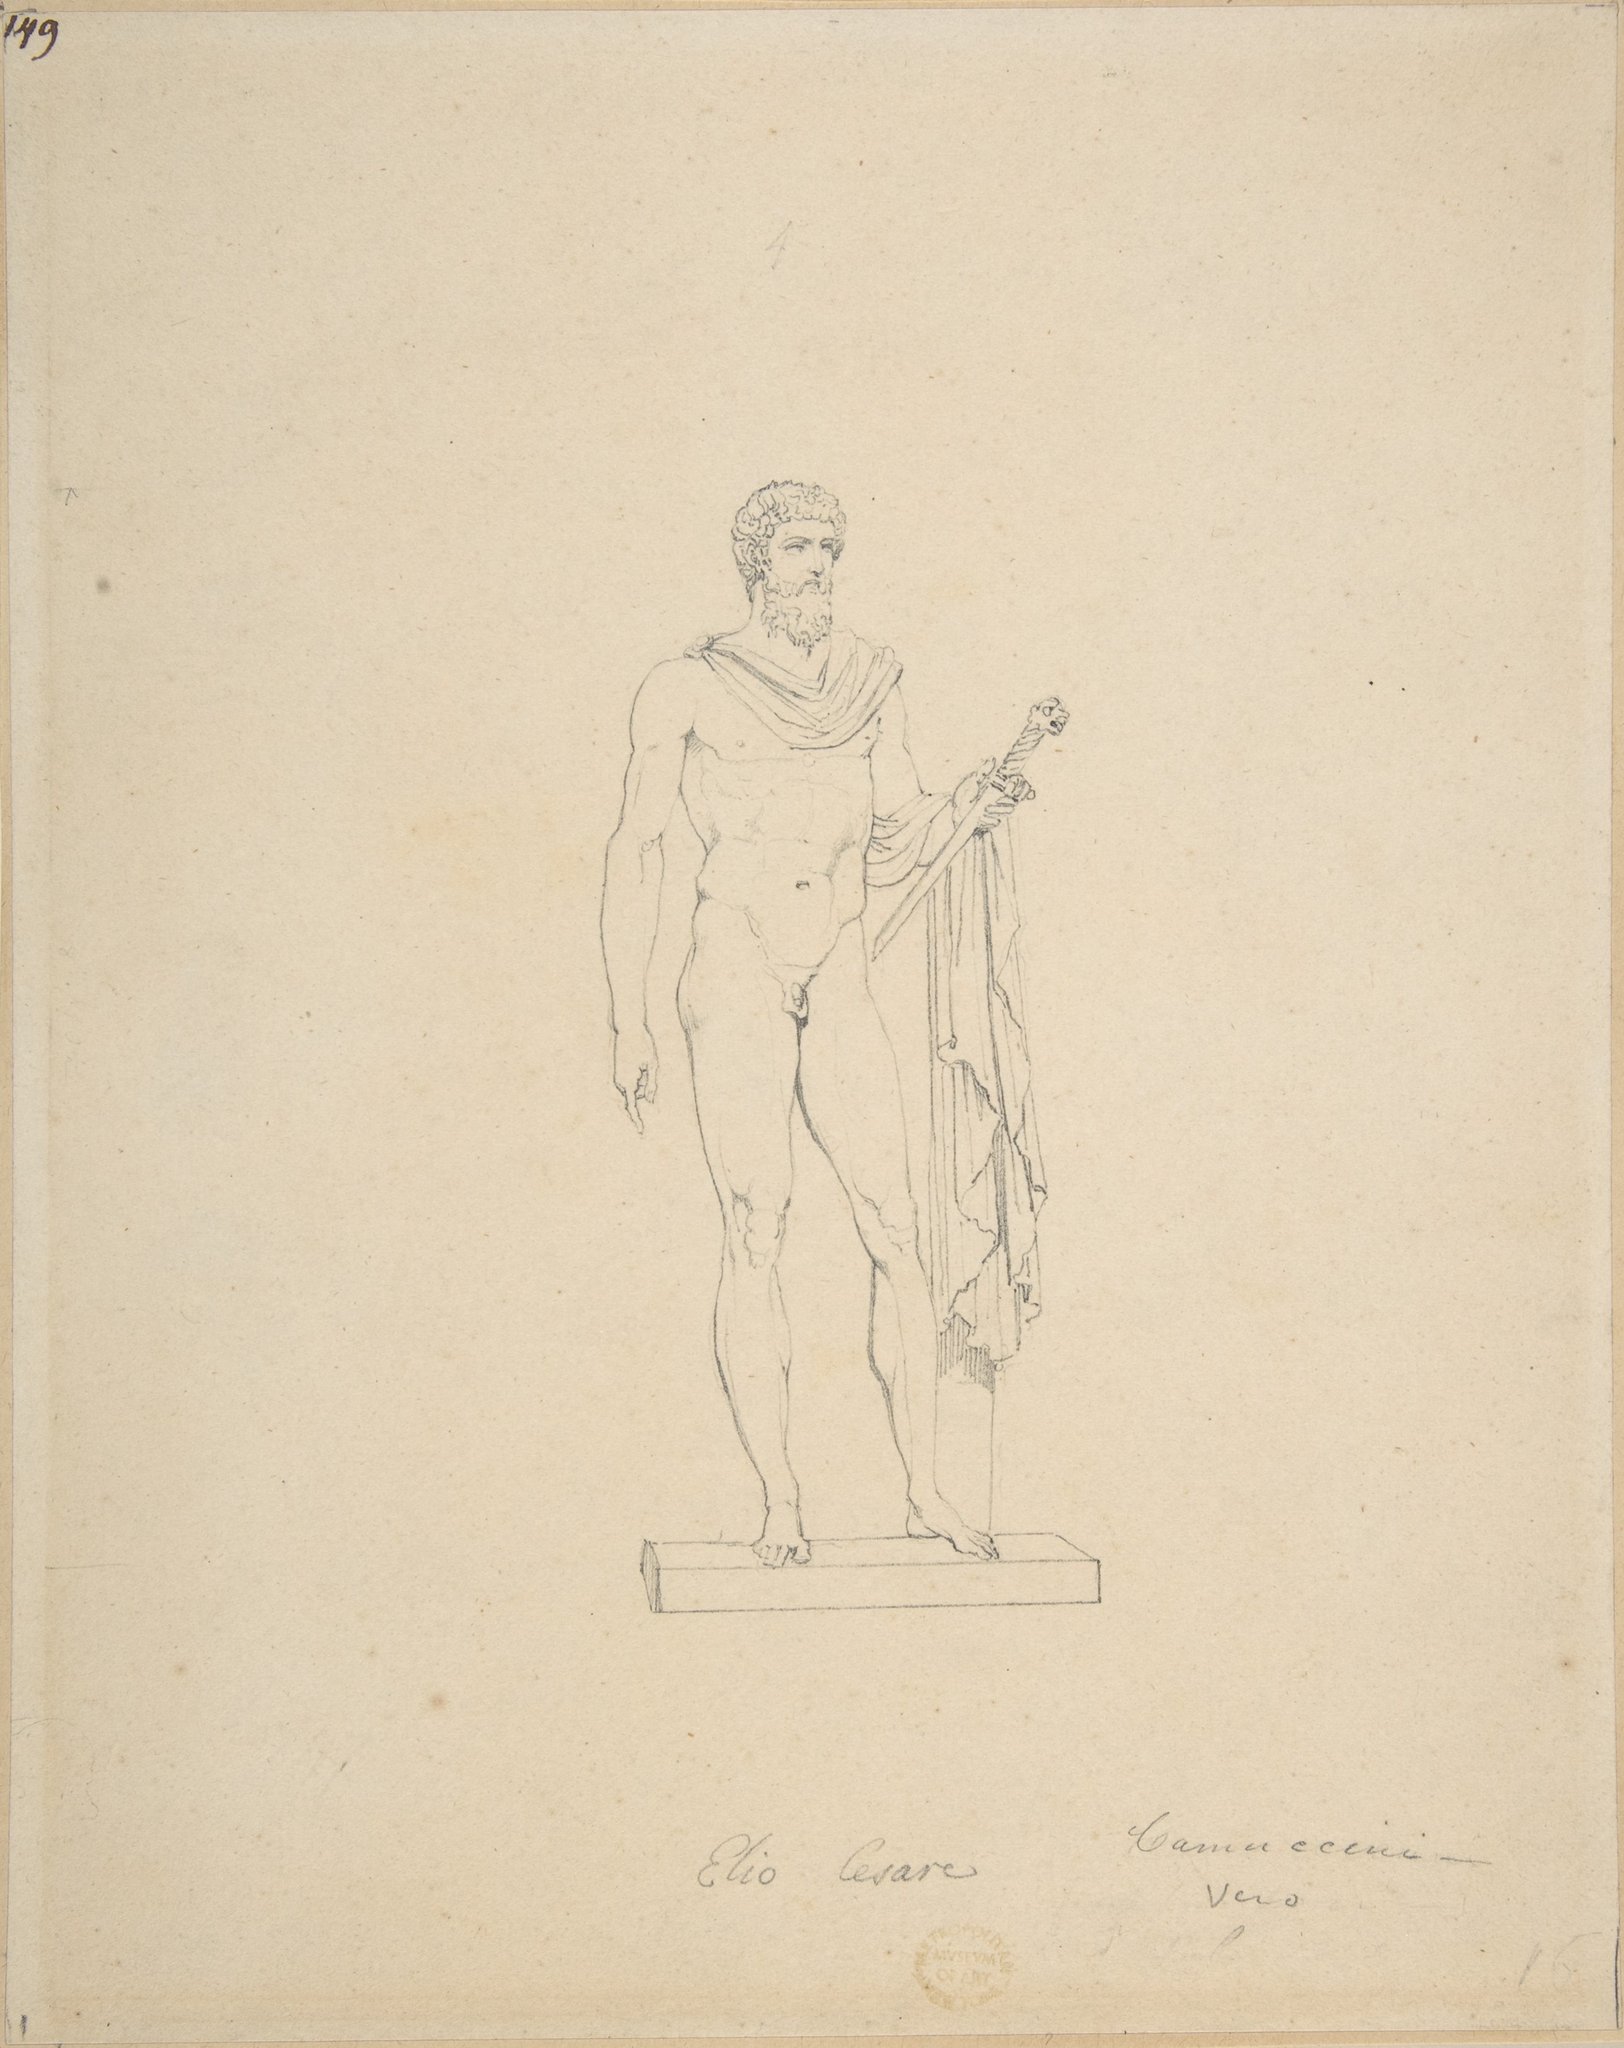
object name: drawing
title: Statue of Caesar as a Divinity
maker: vincenzo camuccini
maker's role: artist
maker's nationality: italian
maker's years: 1771-1844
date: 1795-1844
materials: graphite, lead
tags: male nudes